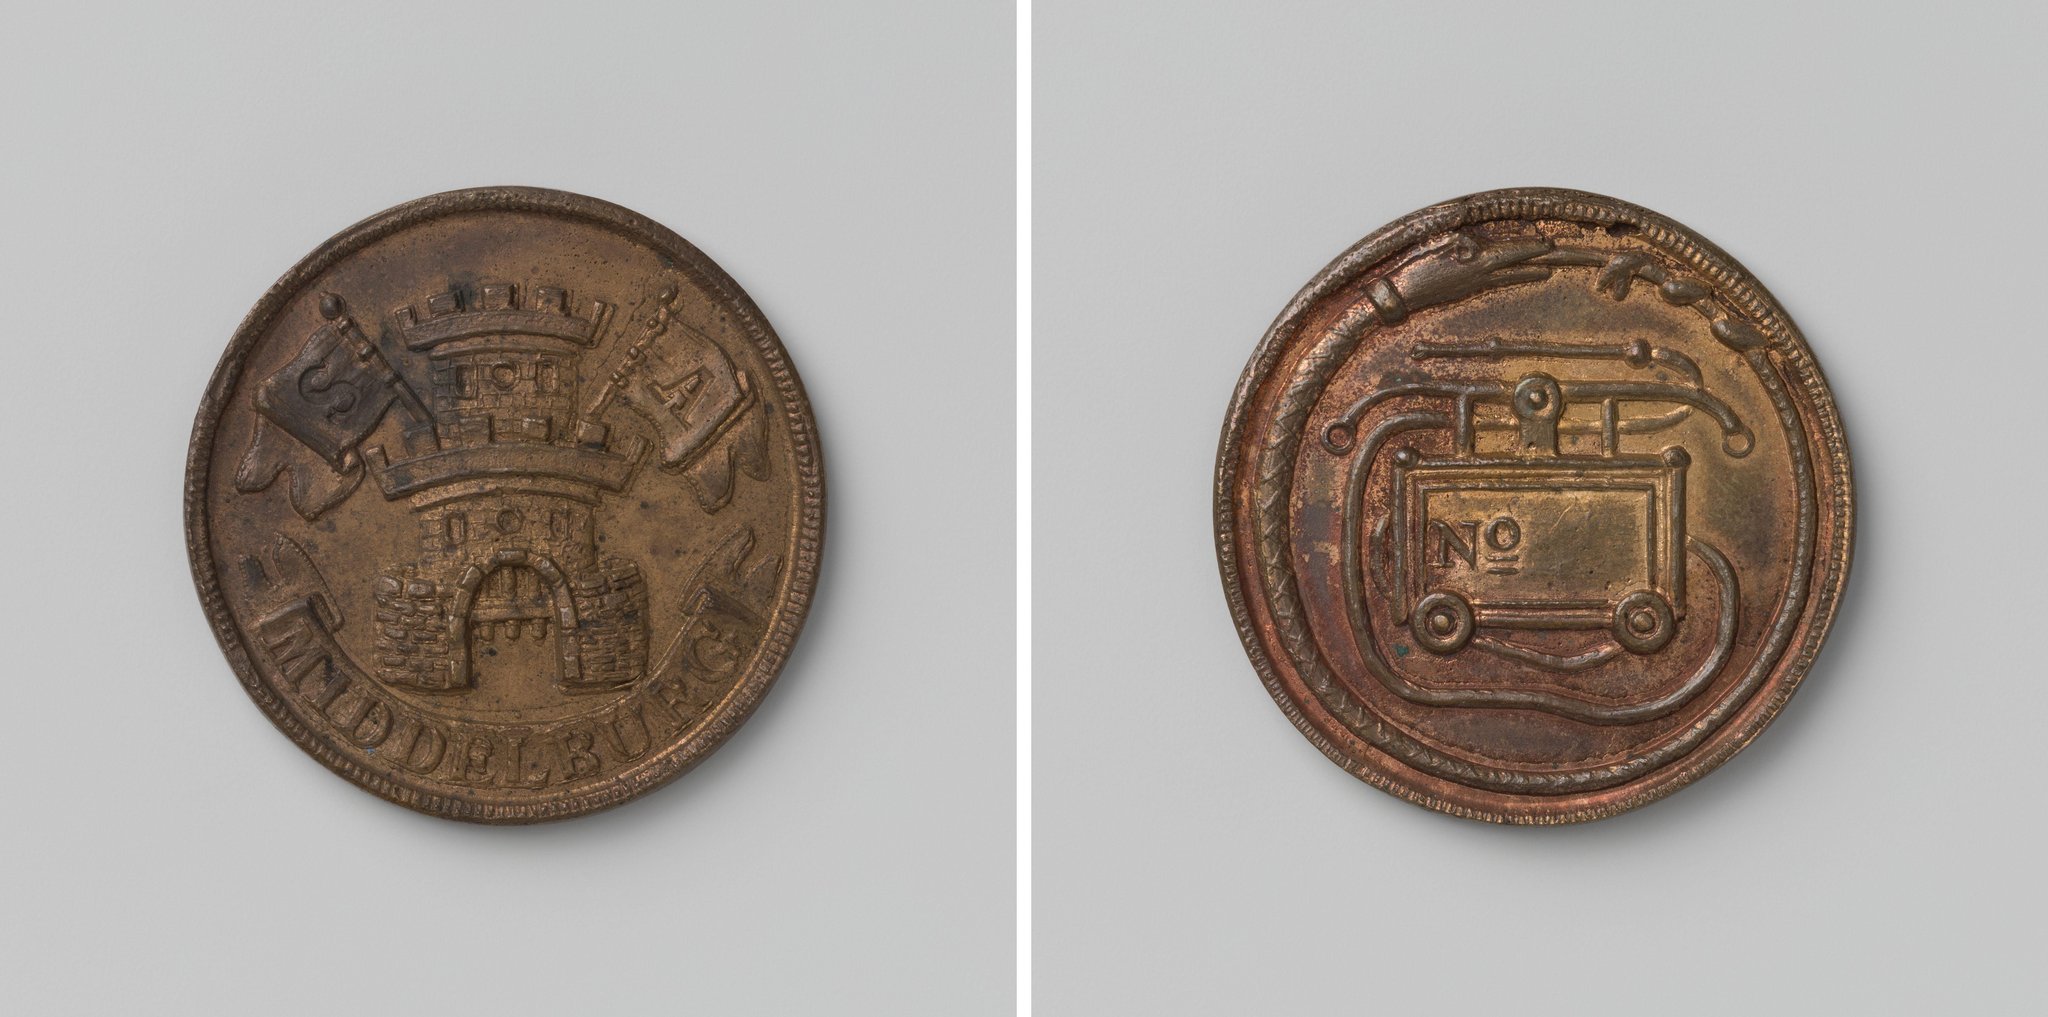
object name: medal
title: Middelburg, brandspuitpenning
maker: Anonymous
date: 1680-1800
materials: brass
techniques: casting, engraving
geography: middelburg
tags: middelburg